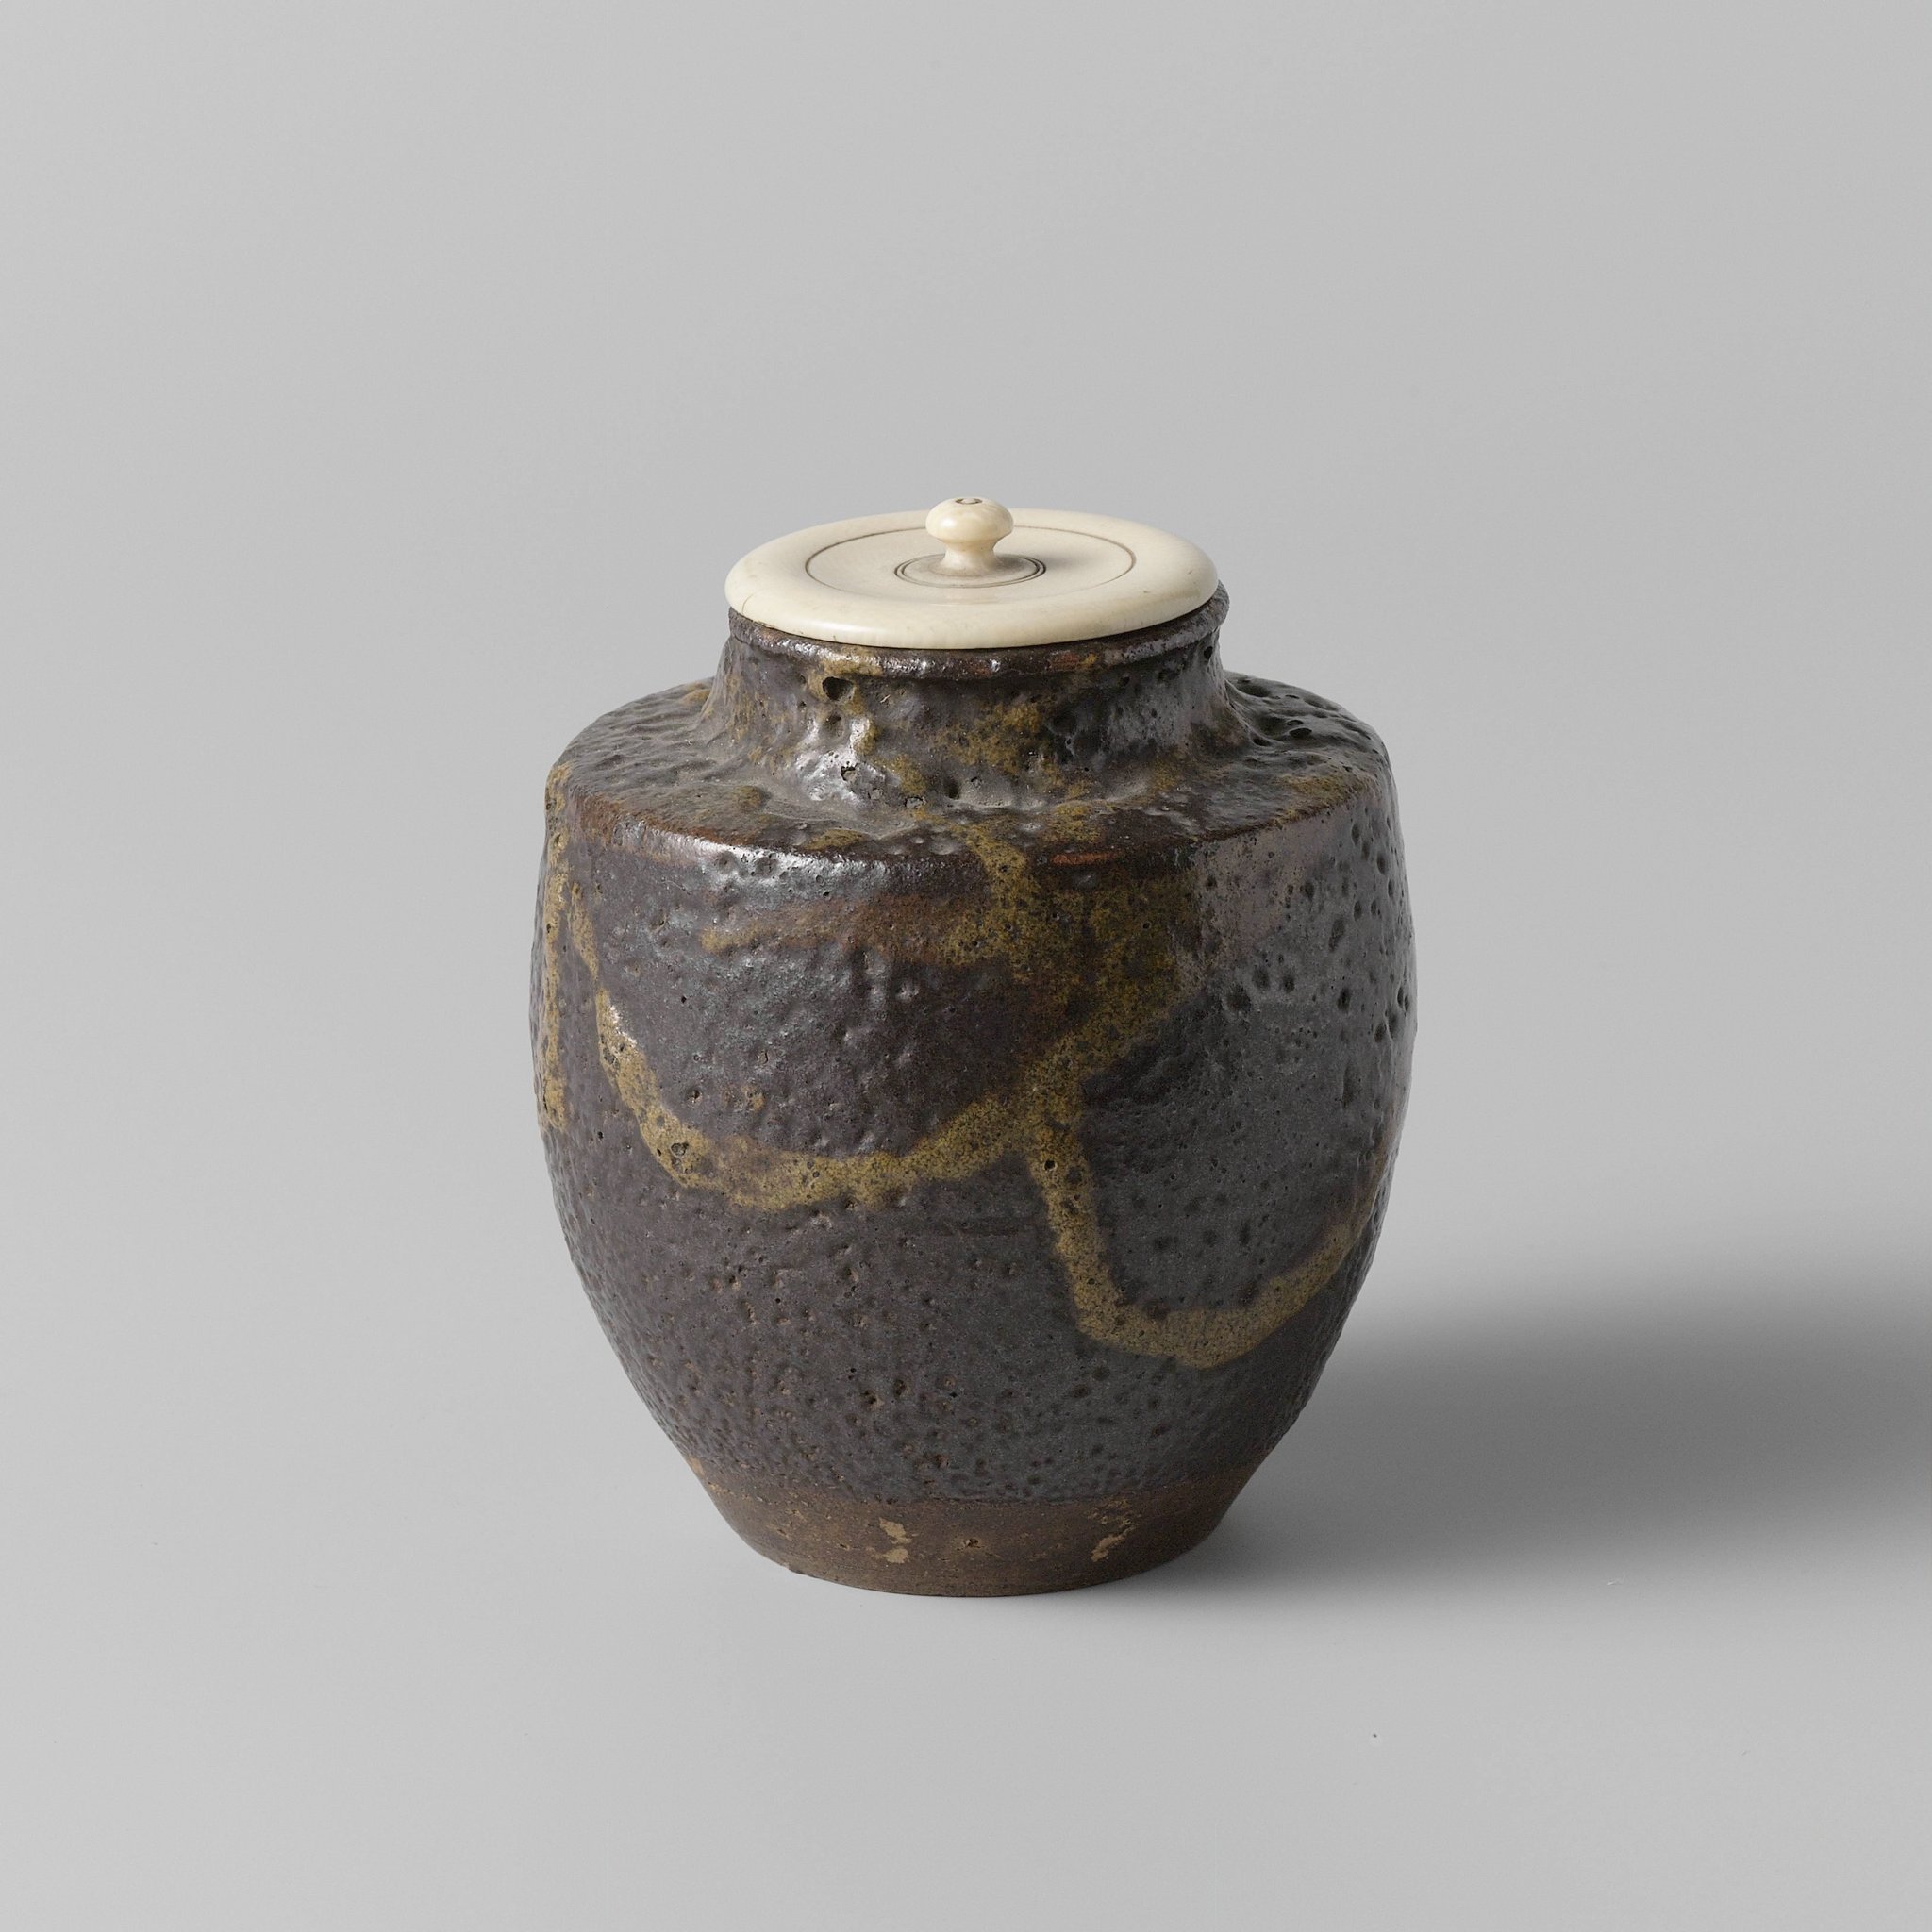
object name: stoftheebus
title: Tea caddy with a green brown glaze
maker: Anonymous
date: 1700-1799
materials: glaze, ivory, stoneware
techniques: firing, turning, vitrification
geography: karatsu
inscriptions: label: ‘Karatsu/ 18e’, label: ‘W587’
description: Stoftheebus of chaire van steengoed met een ivoren deksel, gedeeltelijk bedekt met een groenbruin glazuur. Het onderste deel van de bus is ongeglazuurd. Oud label aan de binnenzijde met 'Karatsu/ 18e'; oud label op de onderzijde met 'W587'. Karatsu.